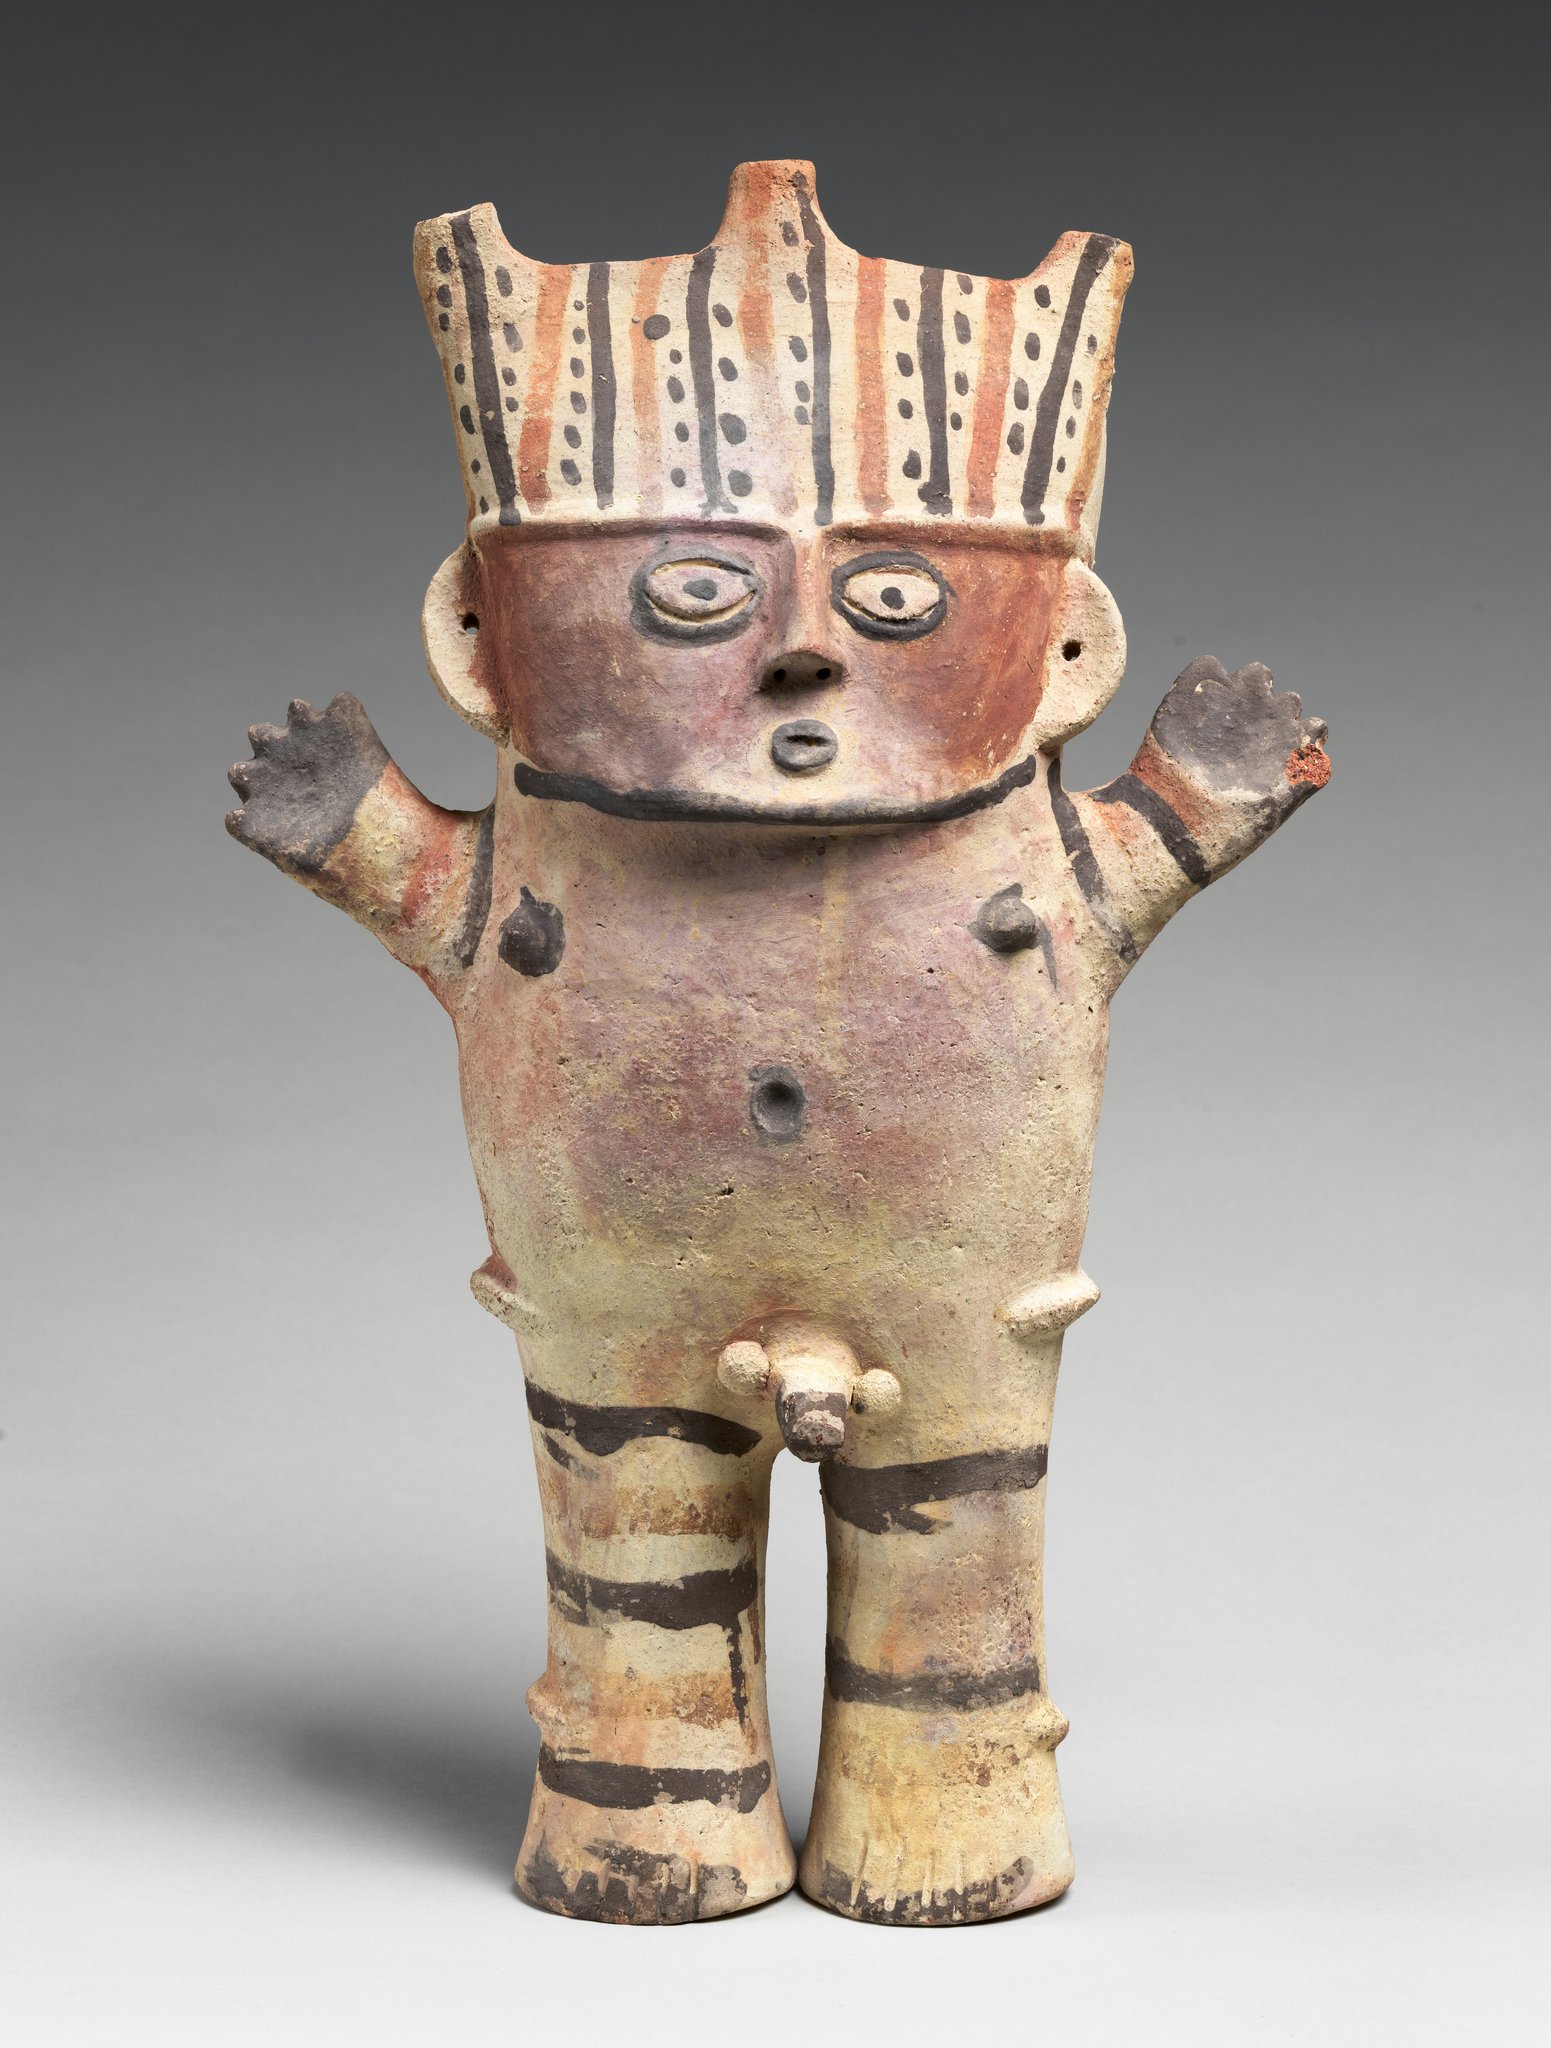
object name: male figure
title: Standing Figure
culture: chancay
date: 1101-1400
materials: ceramic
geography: peru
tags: men